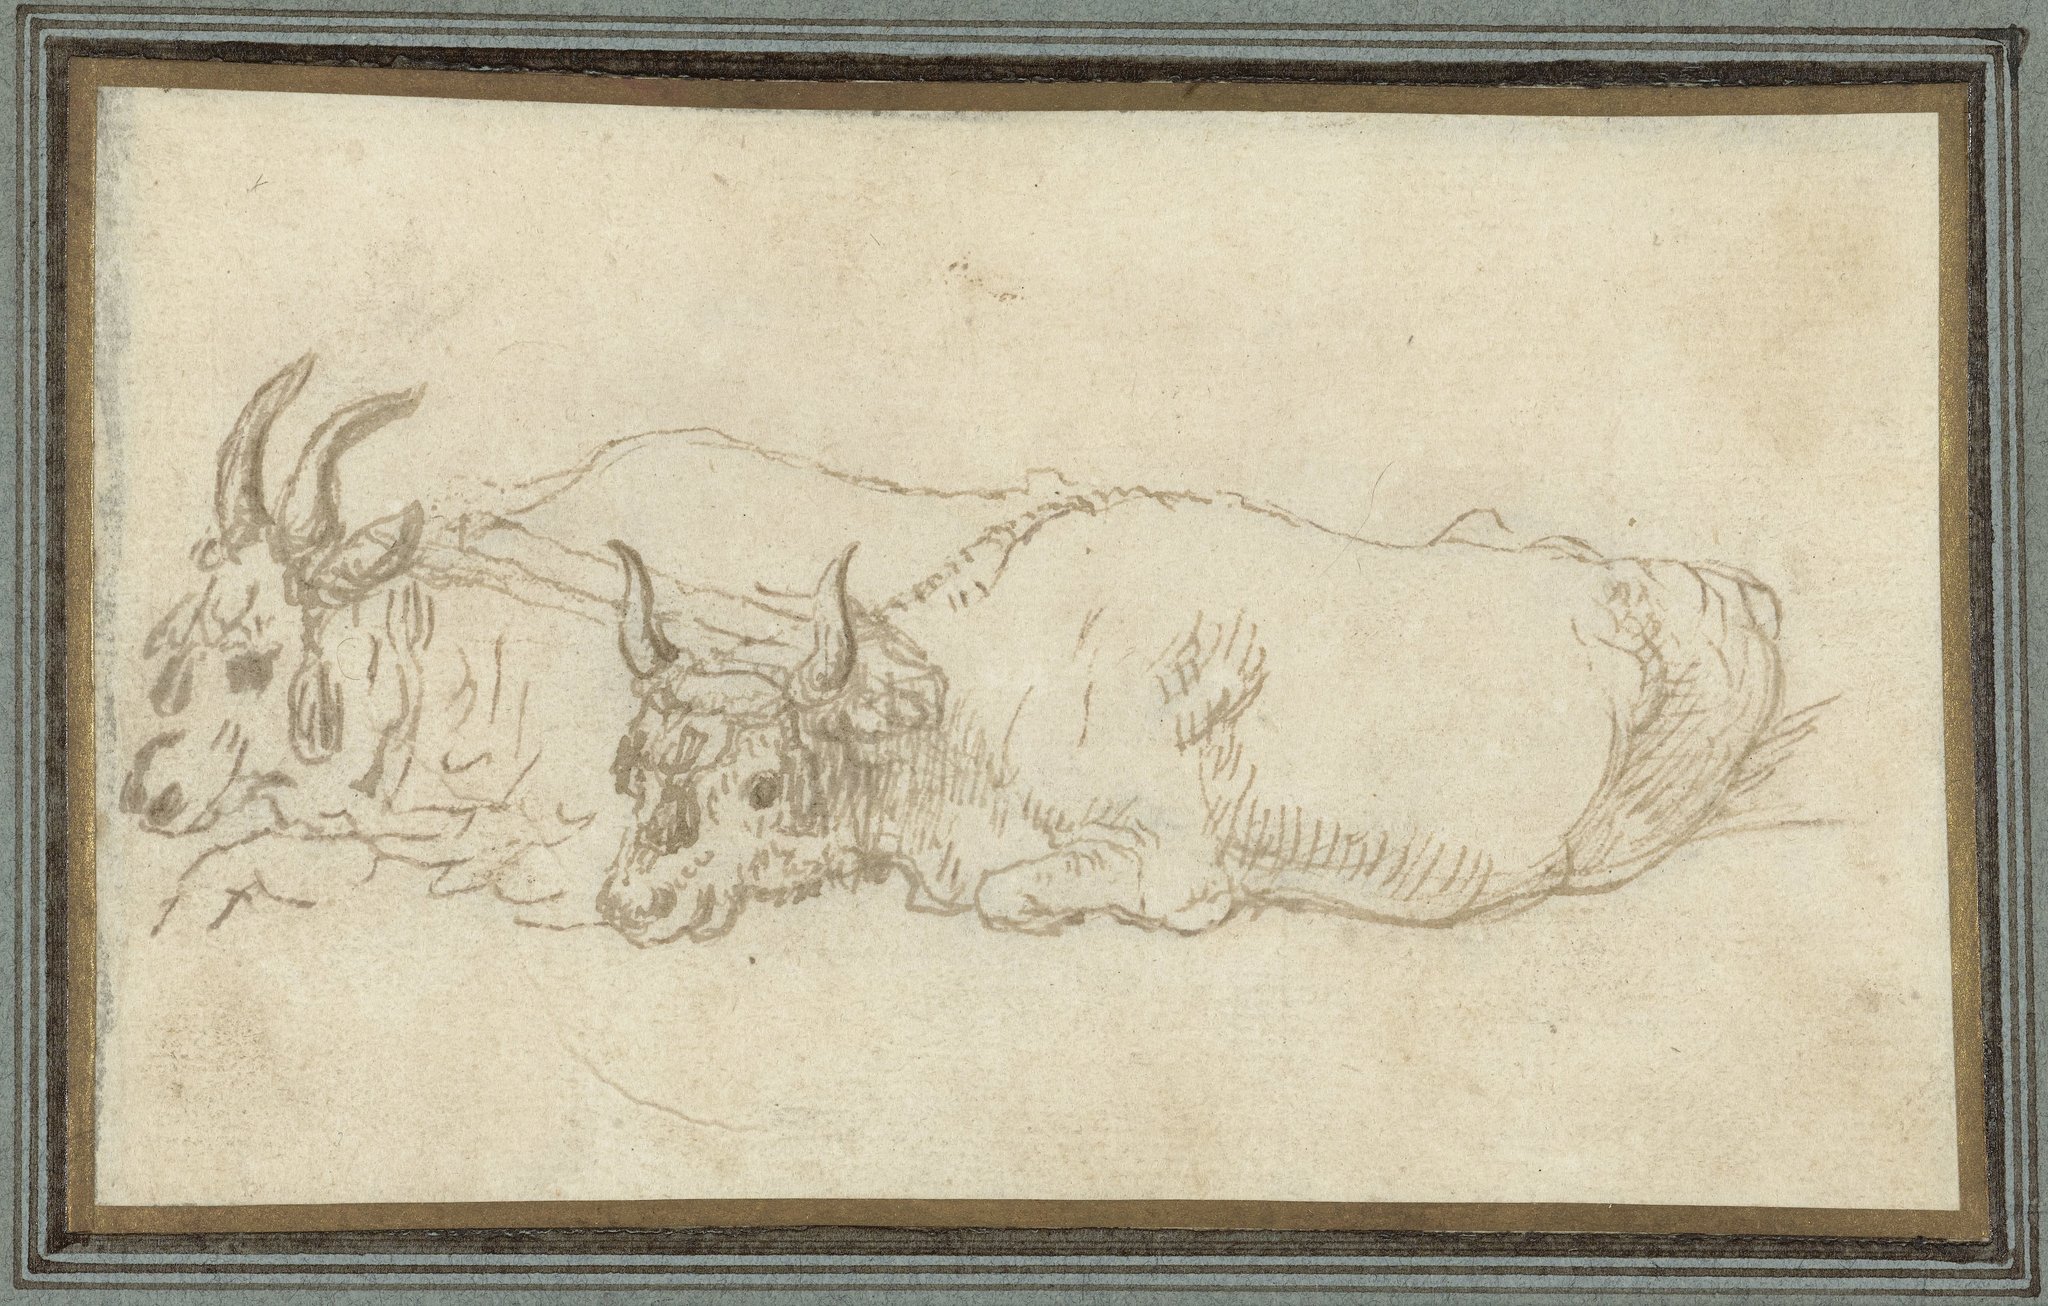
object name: drawing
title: Twee liggende buffels onder een juk gespannen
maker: claude lorrain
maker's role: draughtsman, print maker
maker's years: 1604-1682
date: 1630-1640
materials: ink, paper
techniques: pen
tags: bovine cattle, yoke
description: Studies van dieren uit het zogenaamde Dierenalbum.